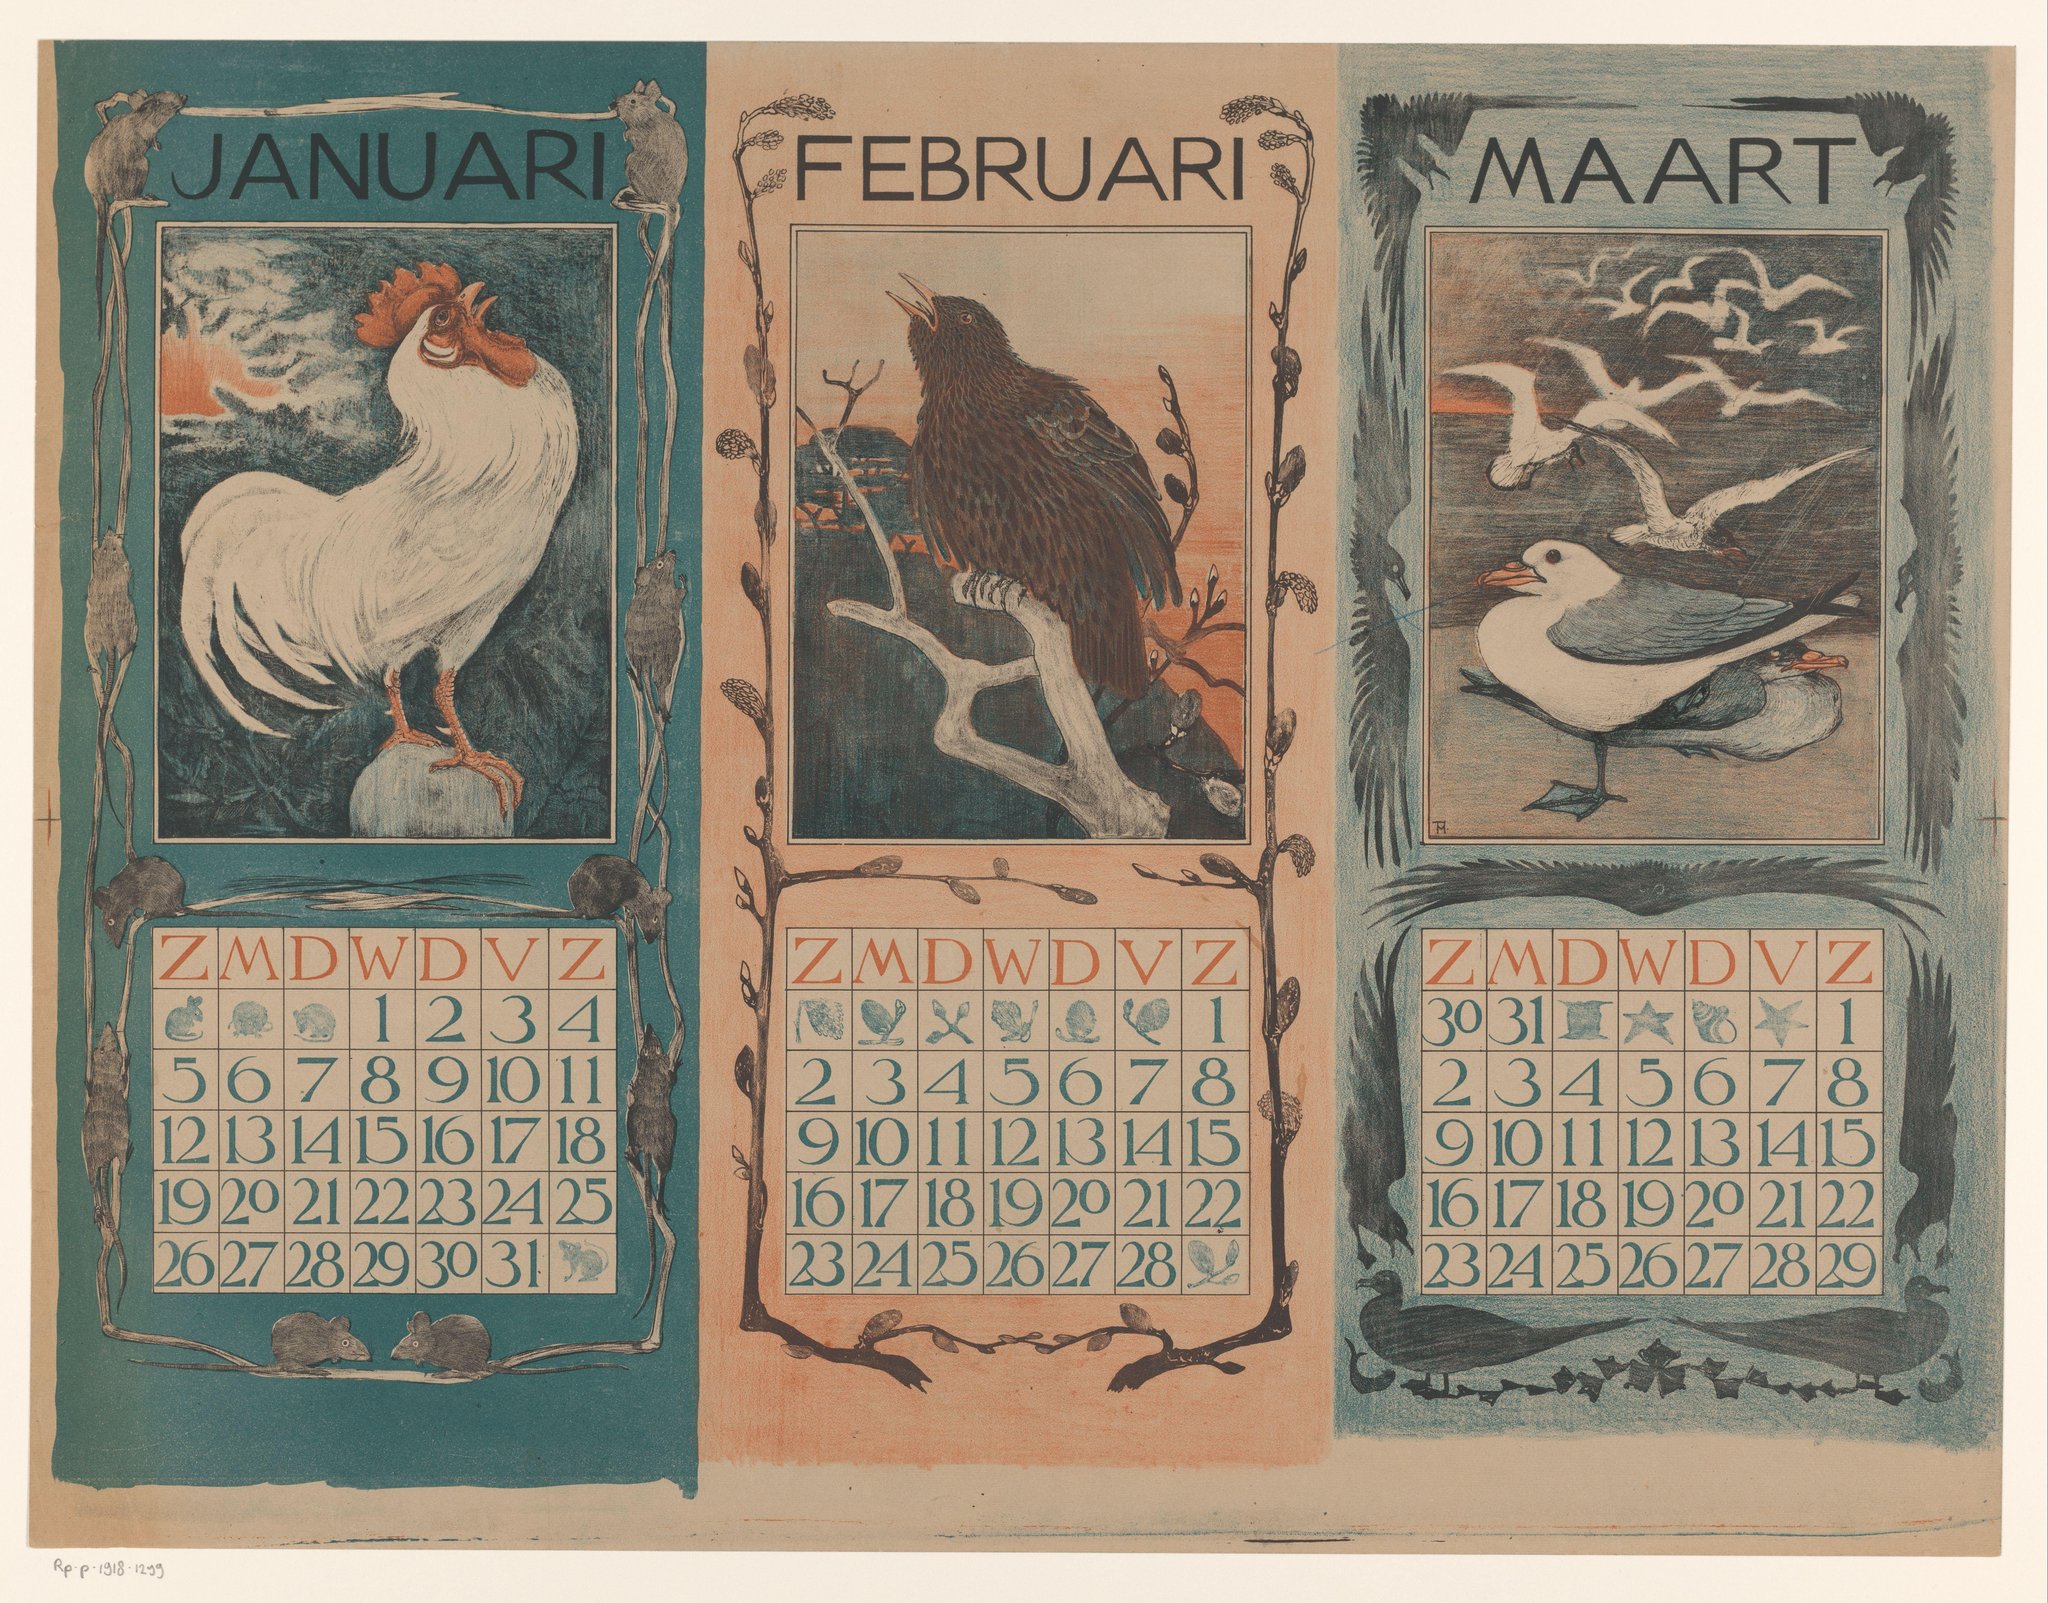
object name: calendar leaf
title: Kalenderbladen van januari, februari en maart, met vogels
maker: theo van hoytema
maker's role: draughtsman, painter, print maker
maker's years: 1863-1917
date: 1901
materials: paper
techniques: lithograph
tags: calendar, almanac, birds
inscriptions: collector's mark: Lugt 2233